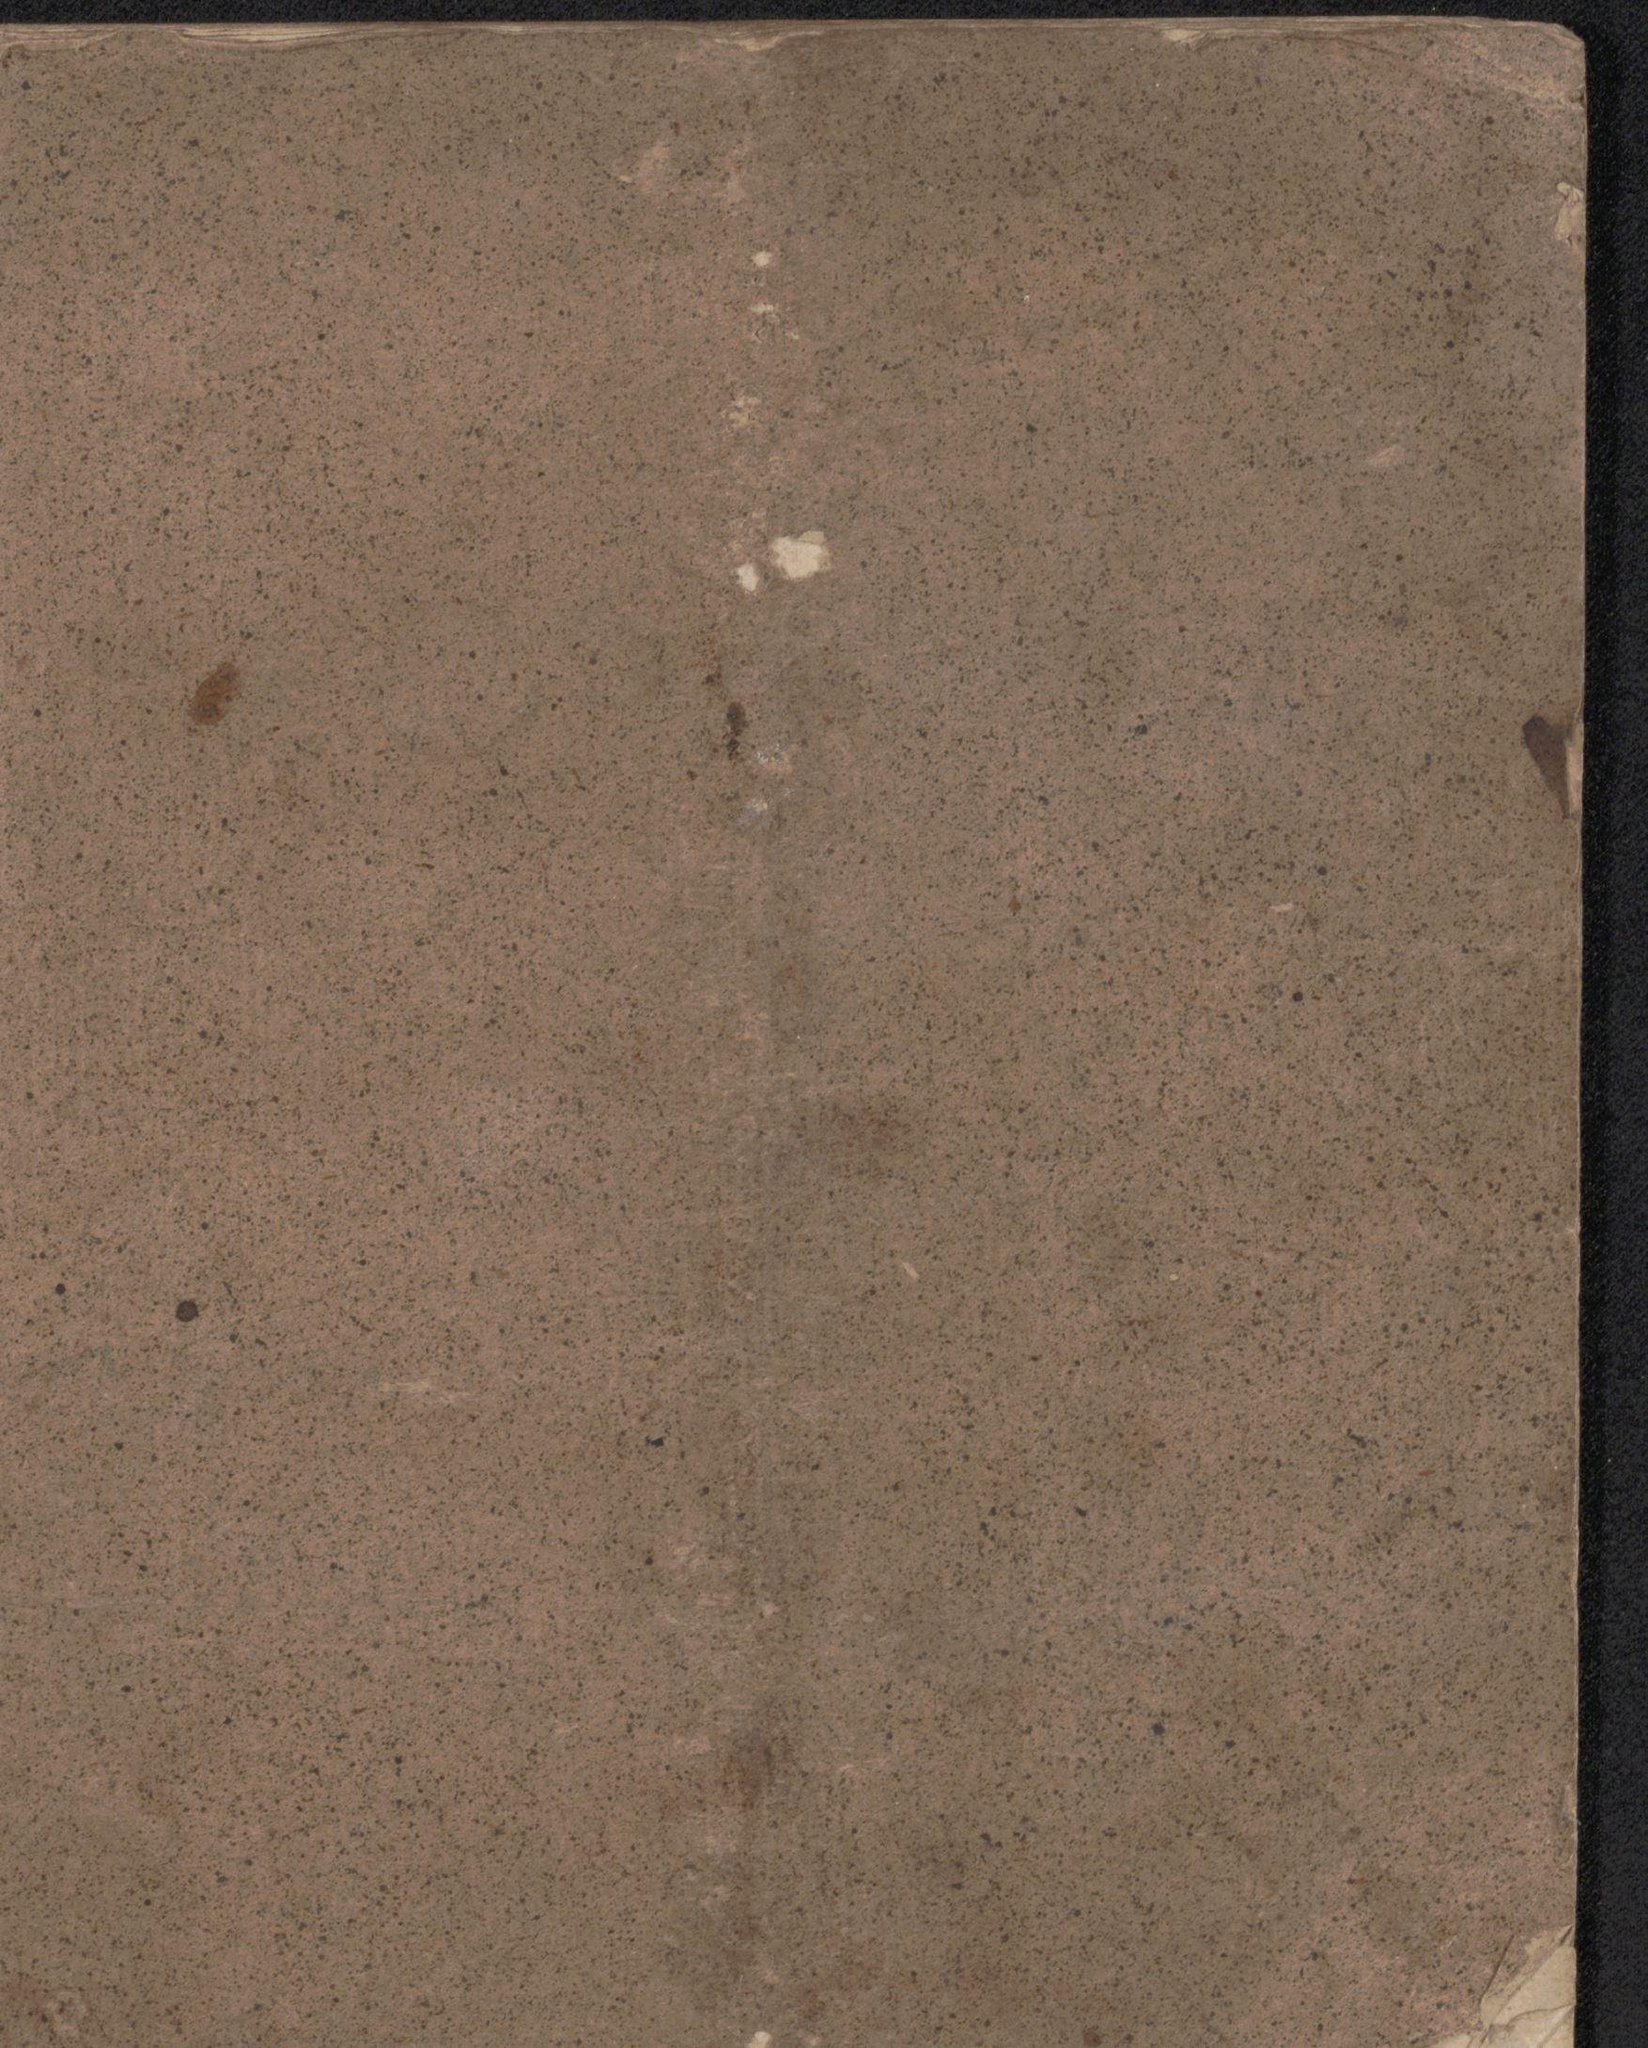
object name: document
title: Reglement voor het Sint Lucas Gilde uit Amsterdam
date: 1797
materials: paper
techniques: printing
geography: amsterdam